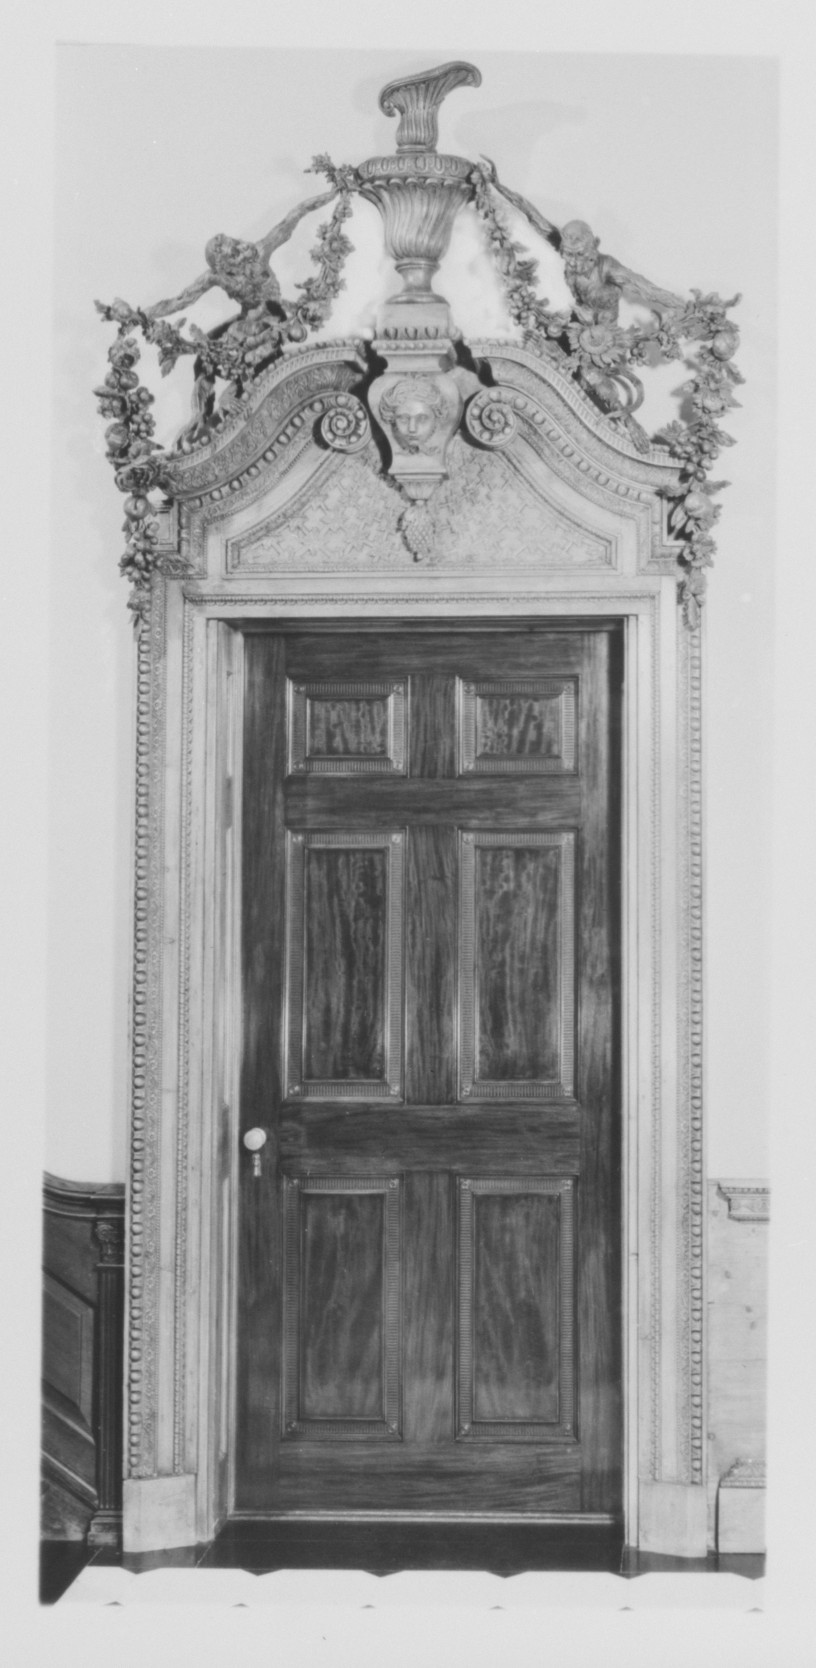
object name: doorcase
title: Doorcase for the Great Drawing Room of Norfolk House, Saint James's Square, London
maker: giovanni battista borra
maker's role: designer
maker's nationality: italian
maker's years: 1713-1770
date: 1755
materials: wood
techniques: carving, gilding, painting